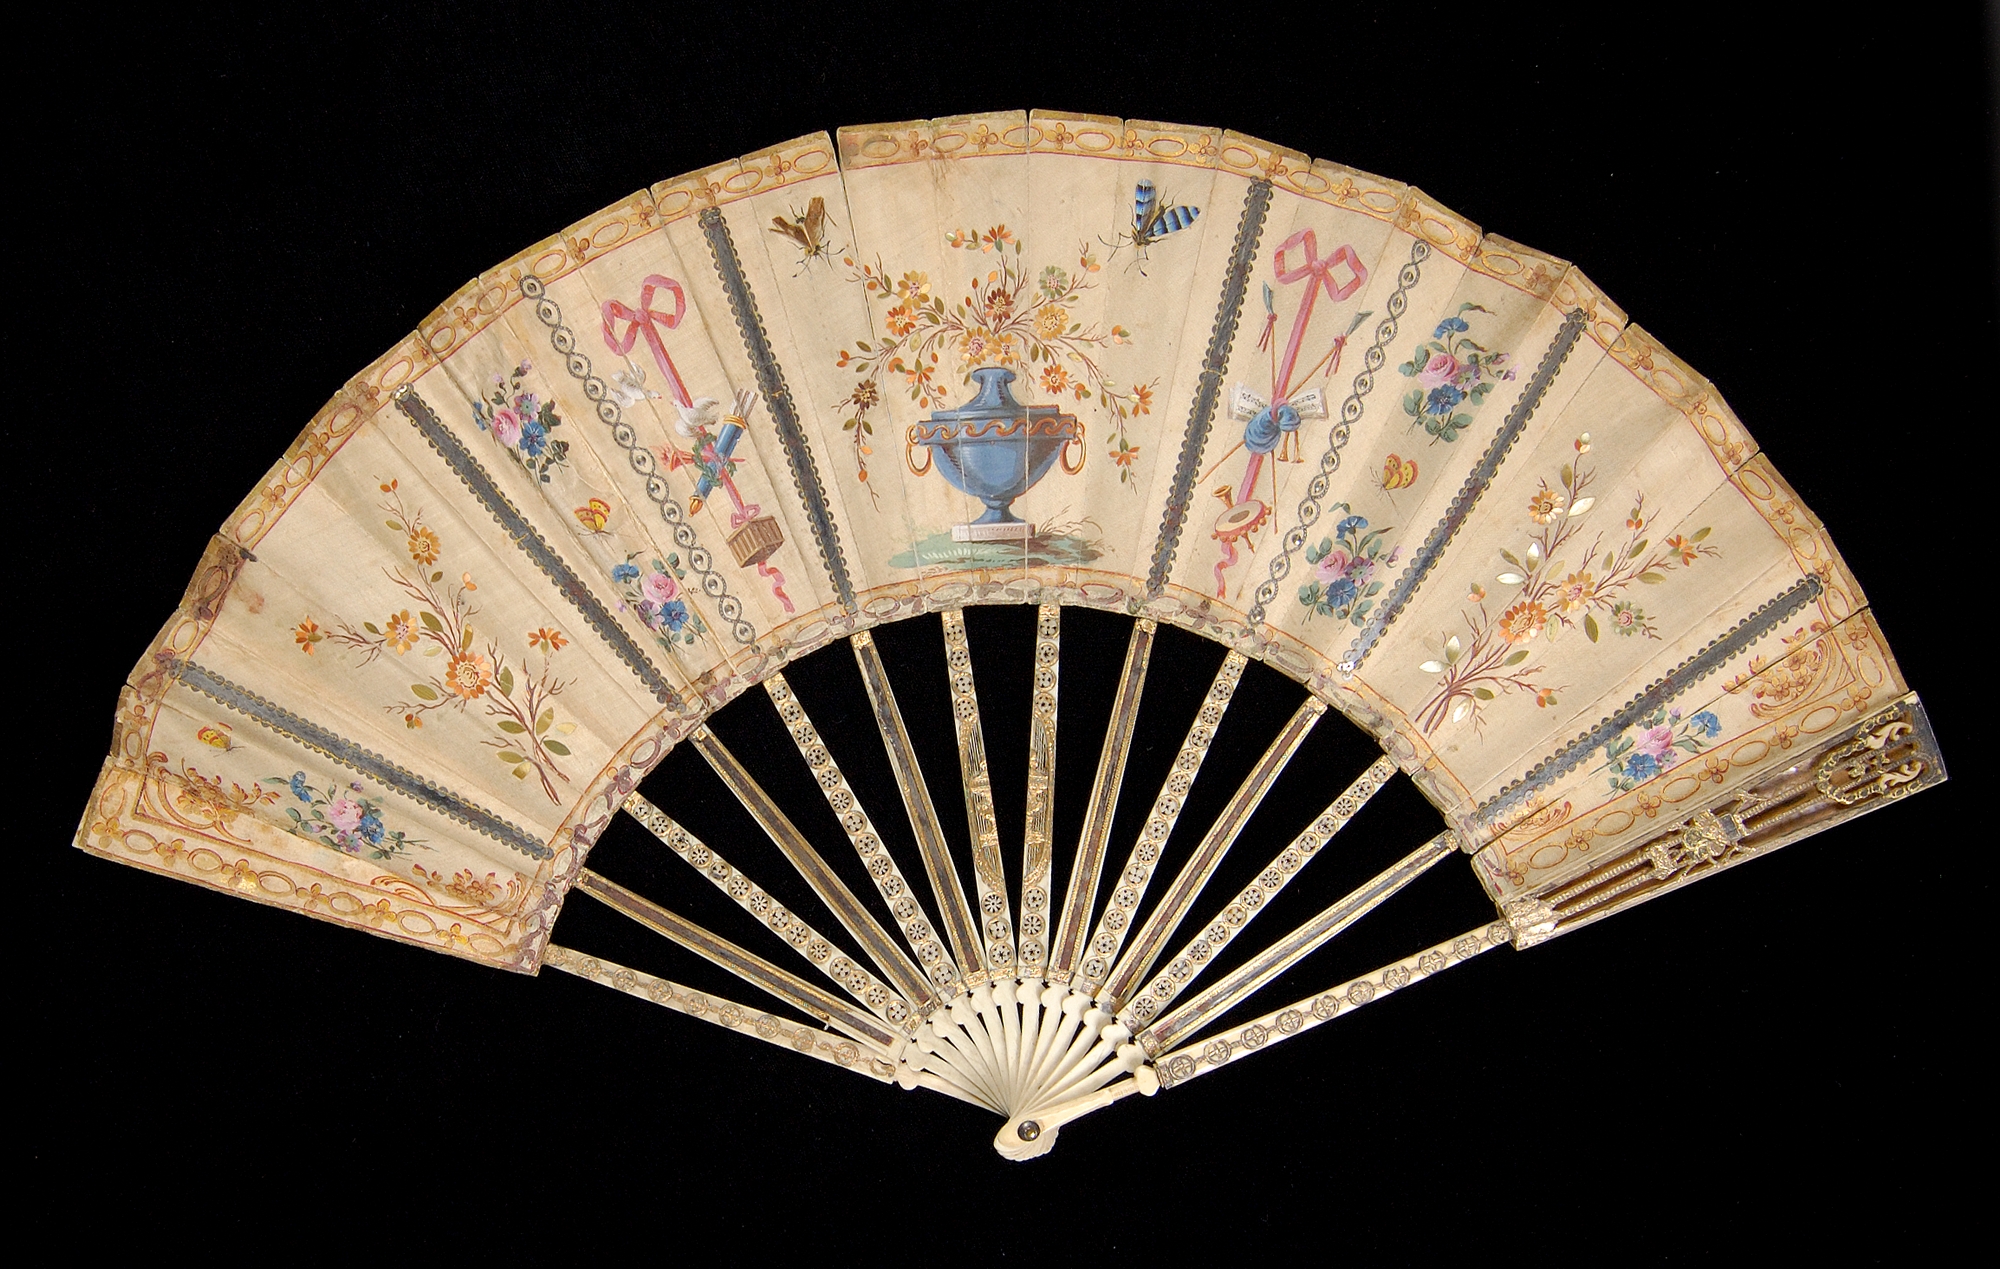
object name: fan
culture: french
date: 1801-1825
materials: ivory, mother of pearl, silk, fiber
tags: insects,flowers